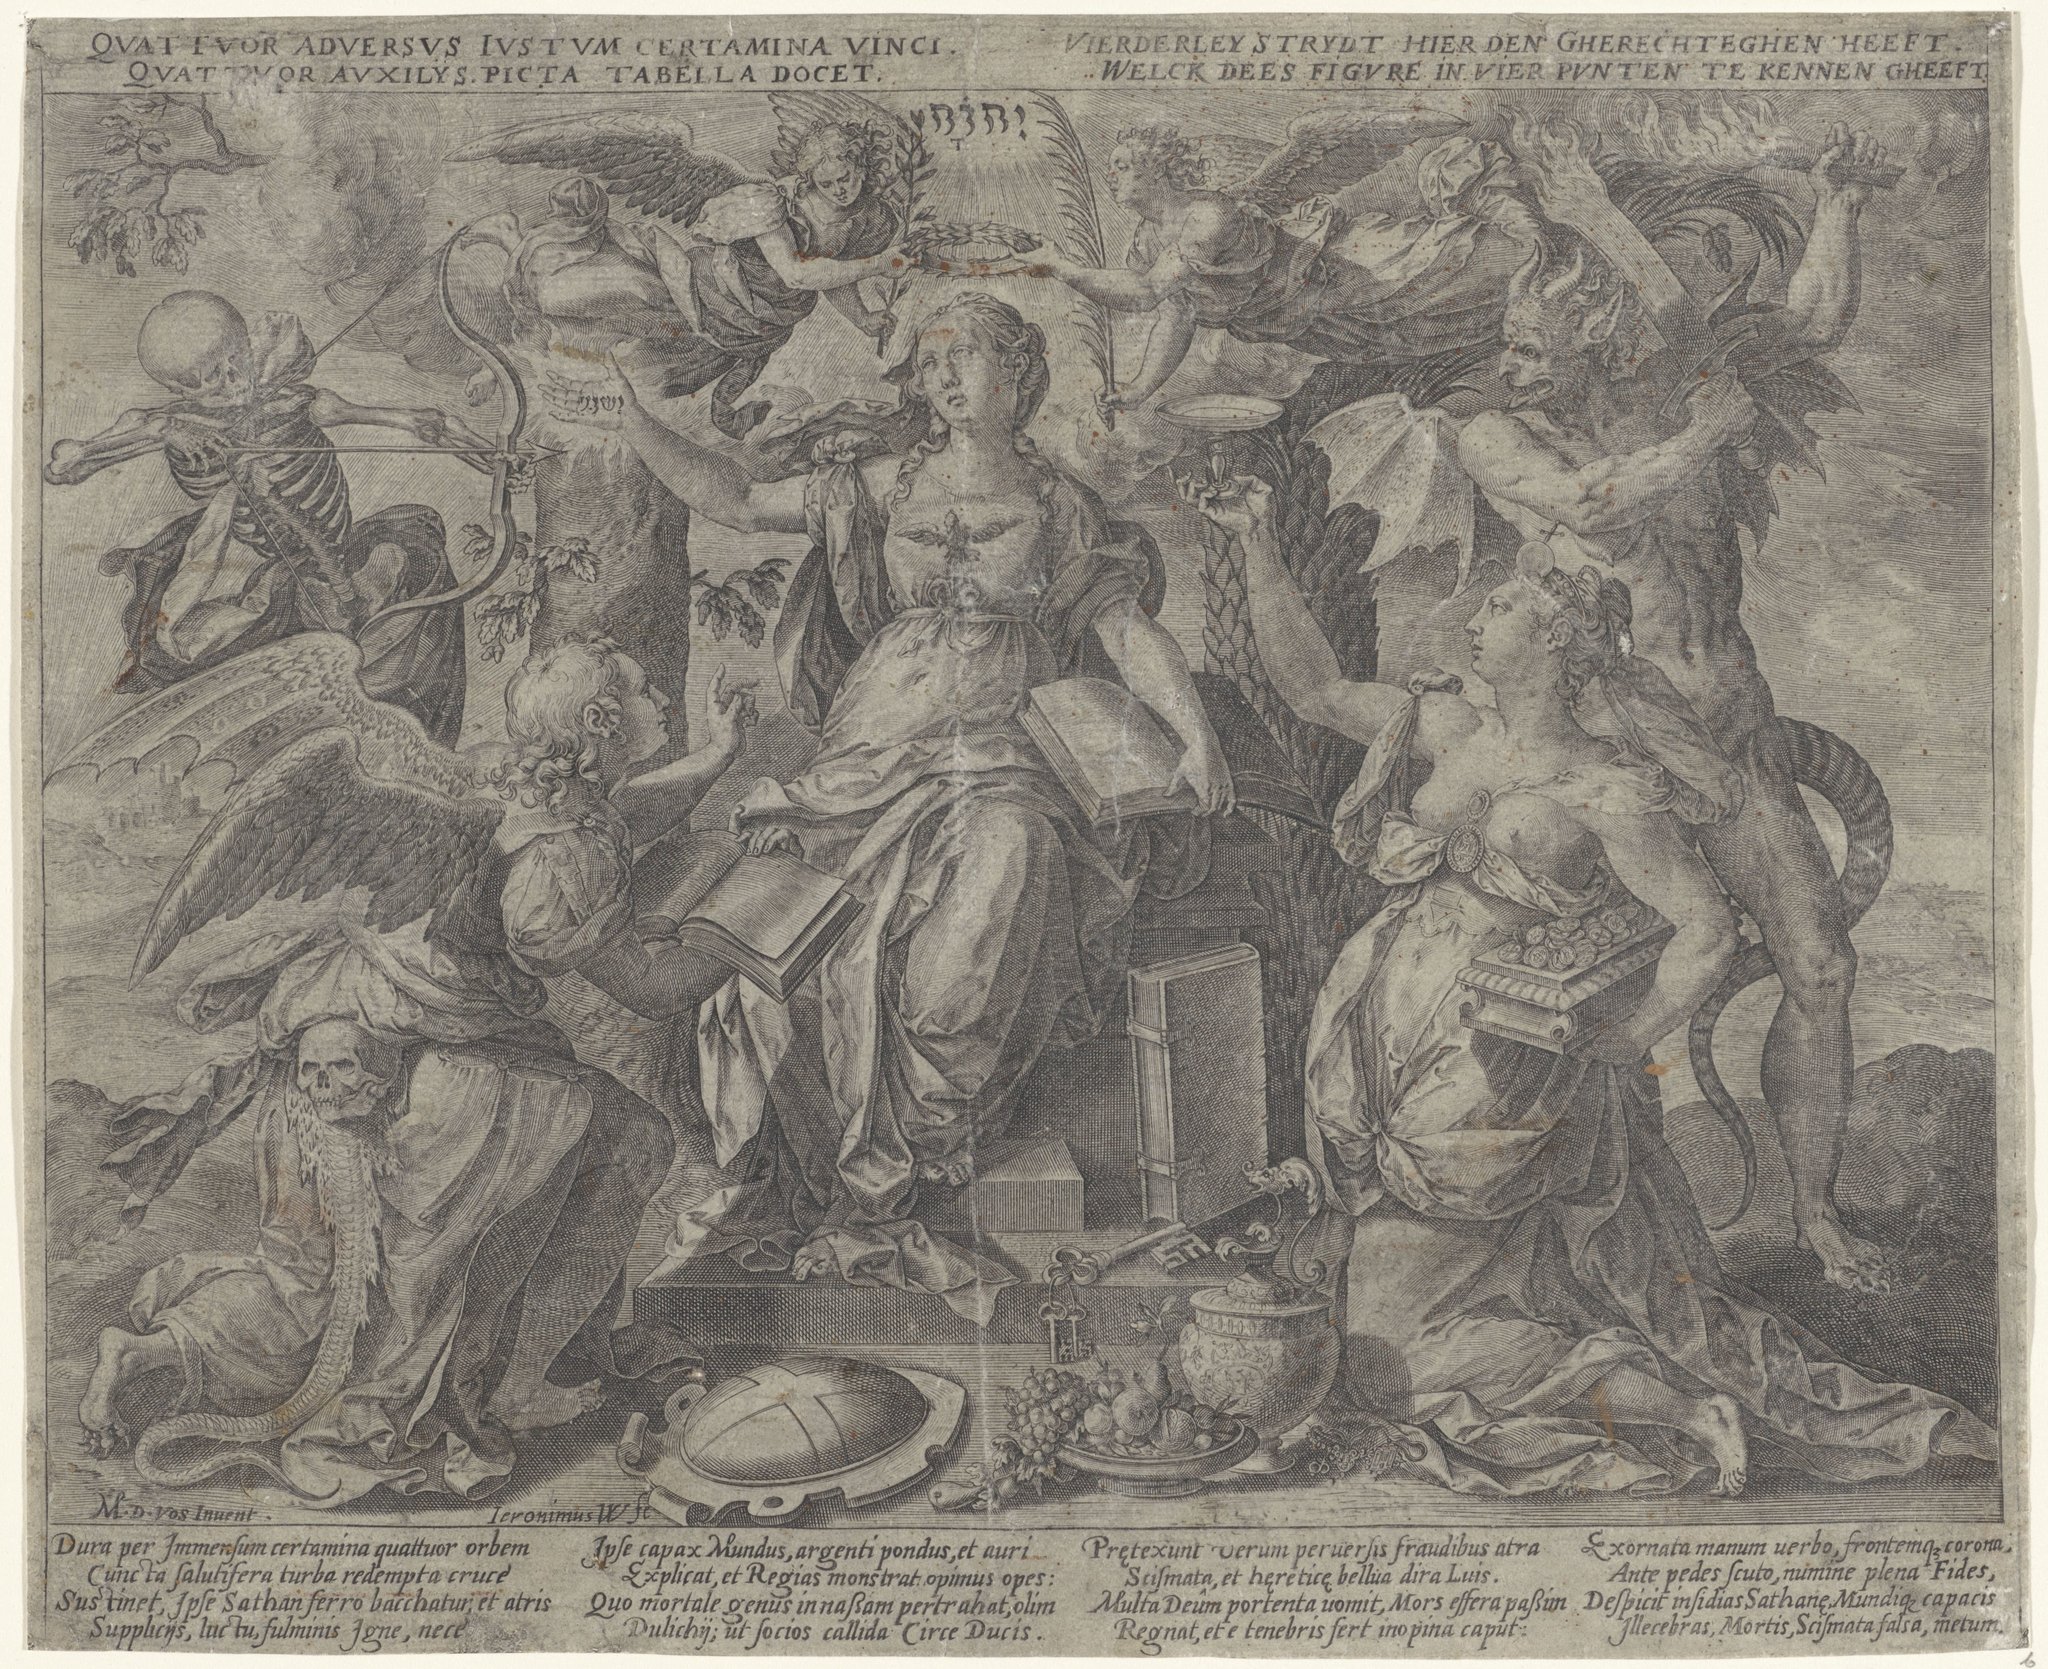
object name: print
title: De vier vijanden van de ware gelovige en de theologische deugden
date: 1570-1601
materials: paper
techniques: engraving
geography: antwerp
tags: true religion vs. false religion, death as skeleton, devil(s) and demons, strife between virtues and vices, psychomachy, wealth, opulence; 'opulenza', 'richezza' (ripa), the church or christian religion vs. paganism and unbelief, the worship of god, heresy; 'heresia' (ripa), the true church vs. the false church, heresy or sectarianism; schism, the church vs. the world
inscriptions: collector's mark: Lugt 2228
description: De vier vijanden van de ware gelovige. Allegorische voorstelling waarin de vrouwelijke personificatie van de rechtschapen christen wordt belaagd door vier vijanden: de Dood, de Ketterij, de Wereld en de Duivel. Met onderschrift van 4 kolommen in elk 4 regels Latijn en 4 regels Nederlands. Zinneprent op het Geloof, ca. 1560.